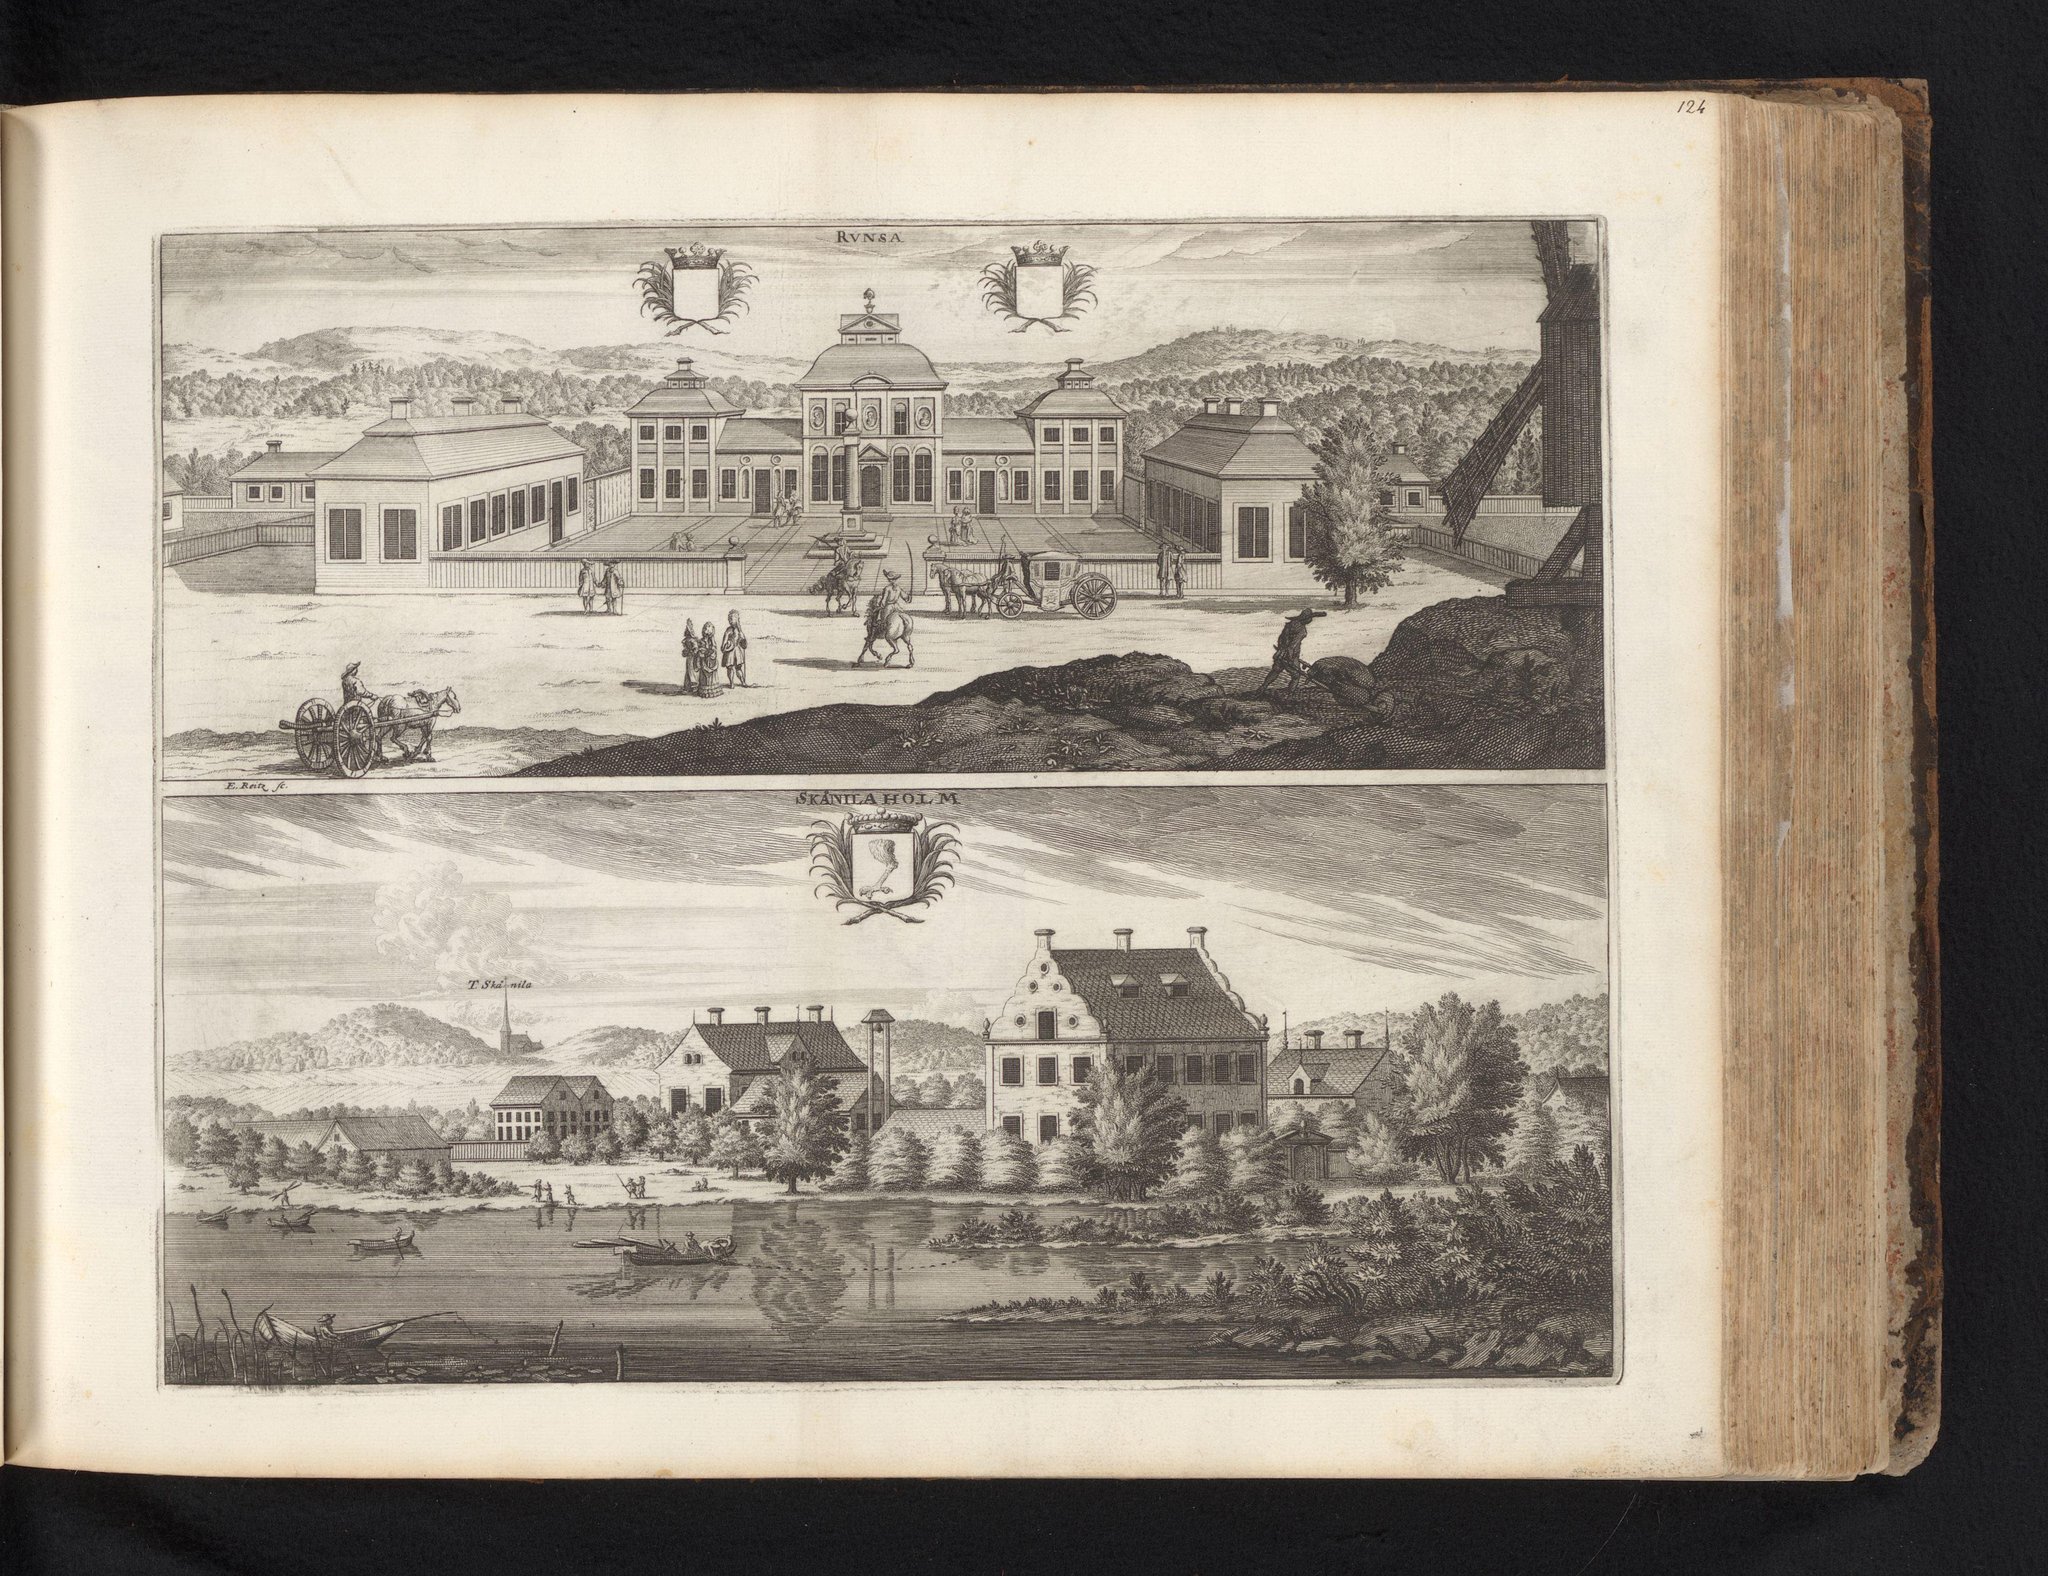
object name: print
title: Runsa / Skånilaholm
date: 1695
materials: paper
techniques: etching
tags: housing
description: Kungliga Biblioteket, 'Suecia': http://www.kb.se/samlingarna/Kartor-bilder/Suecia-antiqua/ (geraadpleegd november 2016).